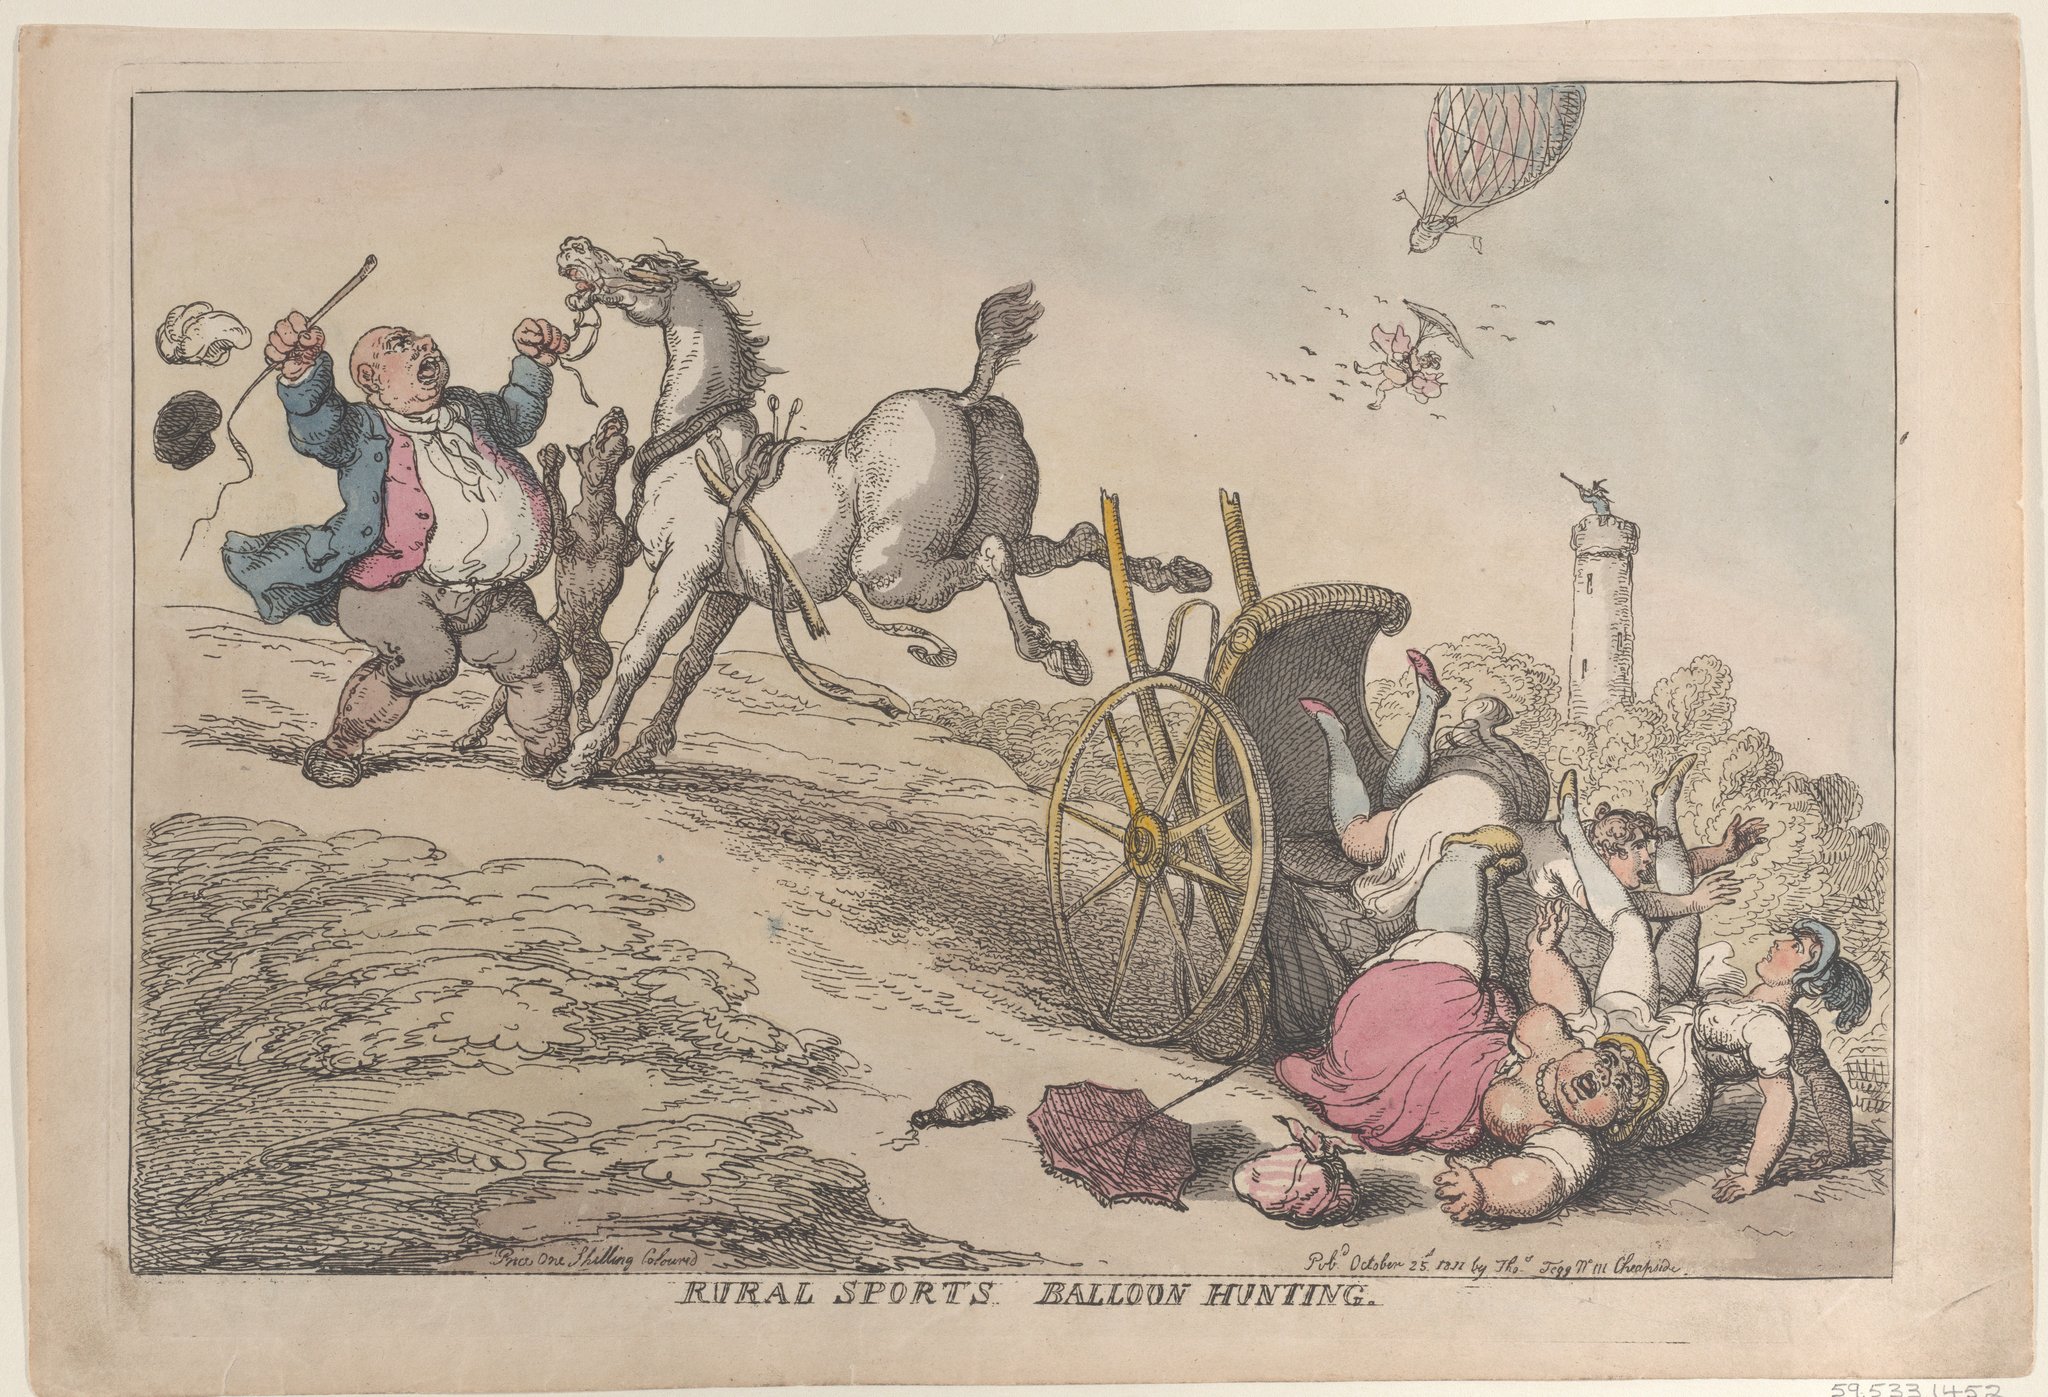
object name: print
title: Rural Sports: Balloon Hunting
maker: thomas rowlandson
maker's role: artist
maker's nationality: british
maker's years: 1757-1827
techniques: etching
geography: london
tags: satire,men,women,horses,carts,hot air balloons